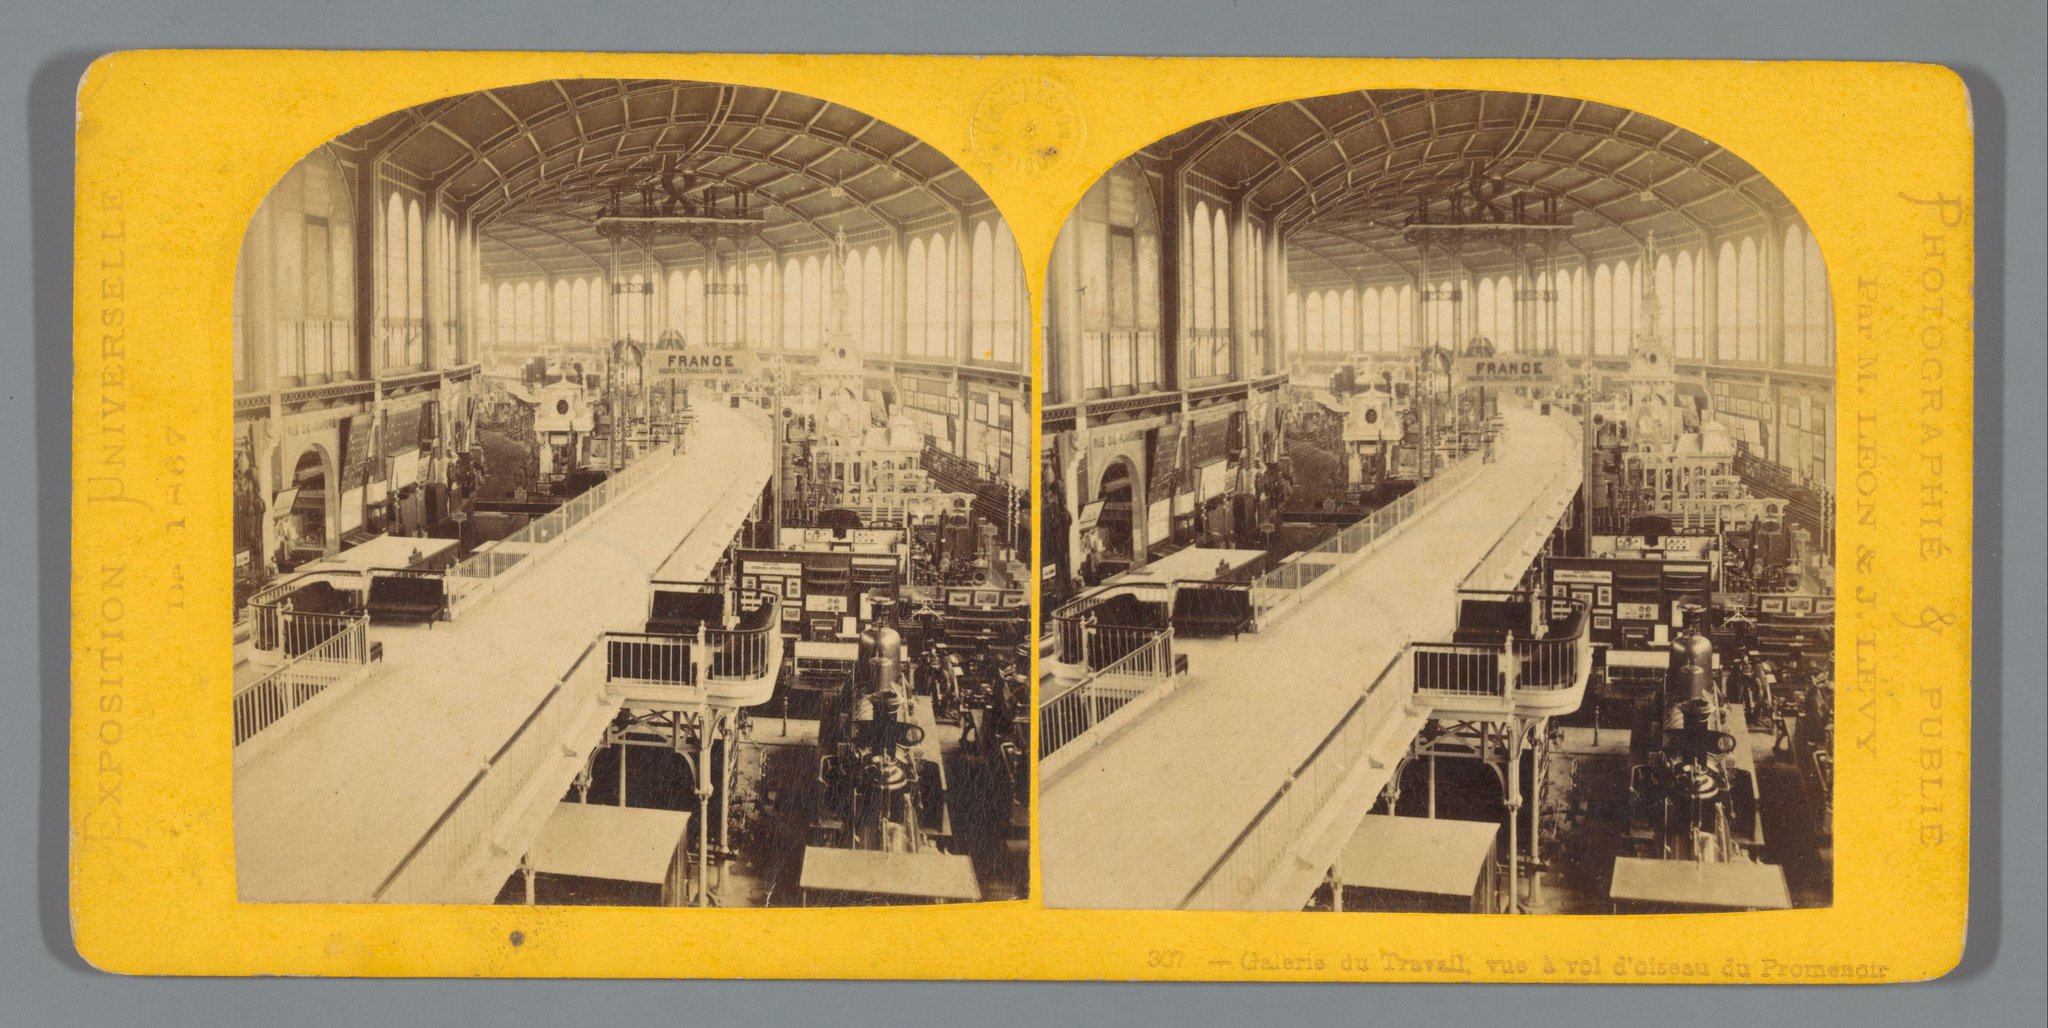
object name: stereograph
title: Galerie du Travail, vue a vol d'oiseau du promenoir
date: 1867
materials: cardboard, paper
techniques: albumen print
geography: paris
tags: world fair, world exhibition, paris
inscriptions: inscription: ‘40’, check stamp: ‘CONCESSION/ */ UNIQUE’, number: ‘307’